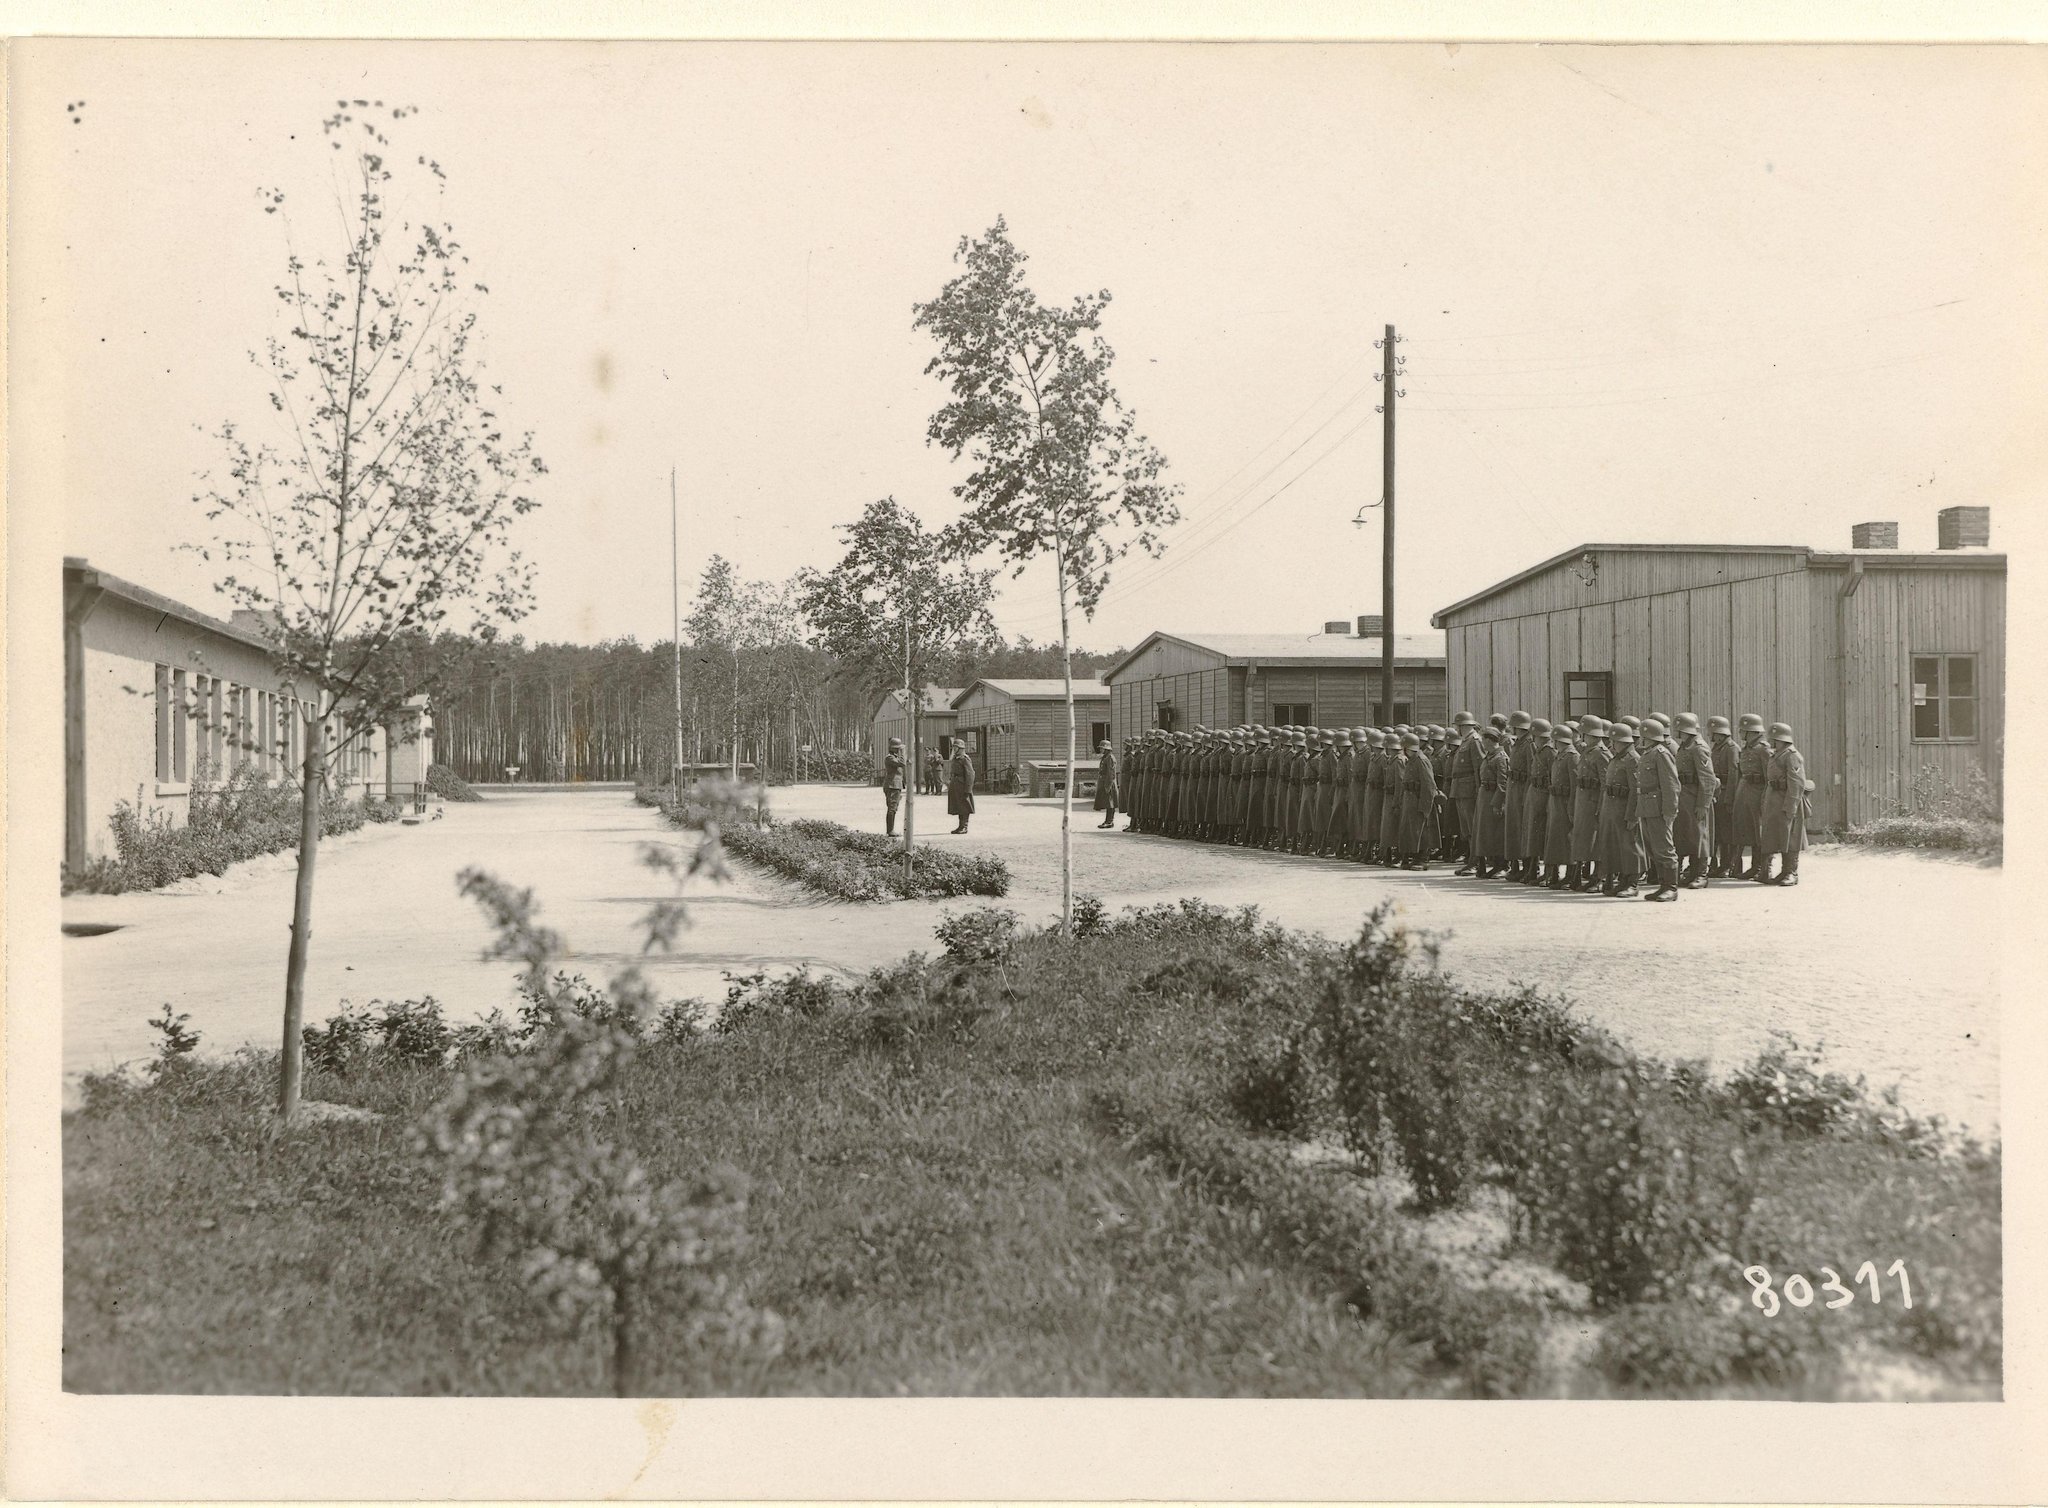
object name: photograph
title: Duitse soldaten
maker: dick w.b. van maarseveen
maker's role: fotograaf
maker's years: 1905-1990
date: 1943-1945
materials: photographic support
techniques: gelatin silver print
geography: muhlberg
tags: the hague, dick w.b. van maarseveen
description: Een groep Duitse soldaten staat opgesteld voor appel in het deel van de kamp waar de Duitse bewakers wonen. Onderdeel van een groep foto's gemaakt door Dick van Maarseveen in het Duitse krijgsgevangenenkamp Stalag IV B in Mühlberg in de periode 1943-1945.